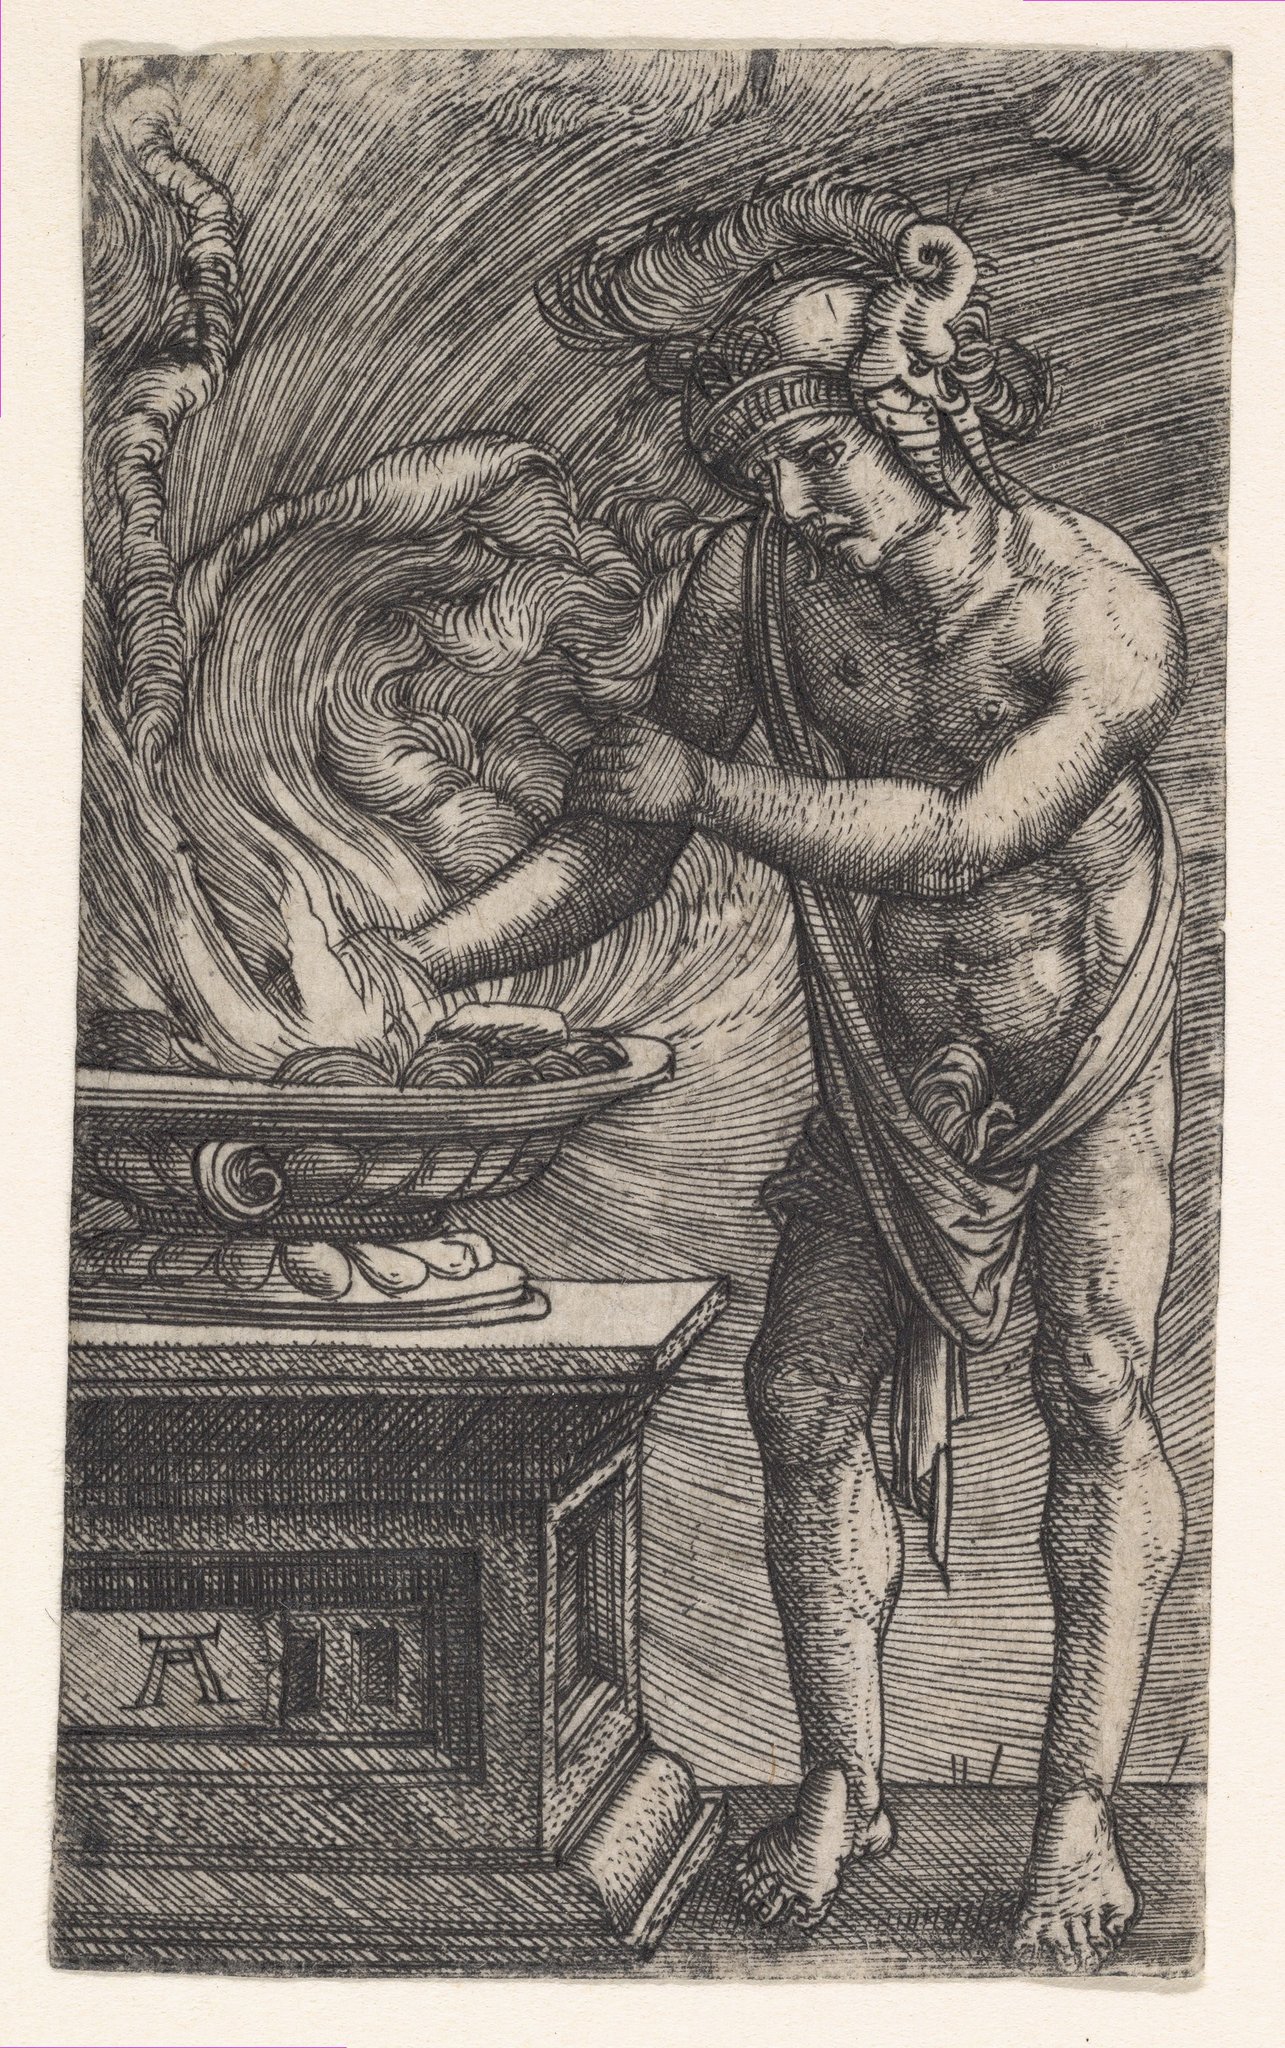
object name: print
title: Mucius Scaevola Burning His Hand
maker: albrecht altdorfer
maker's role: artist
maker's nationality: german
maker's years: 1480-1538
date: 1475-1538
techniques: engraving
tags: men,fire